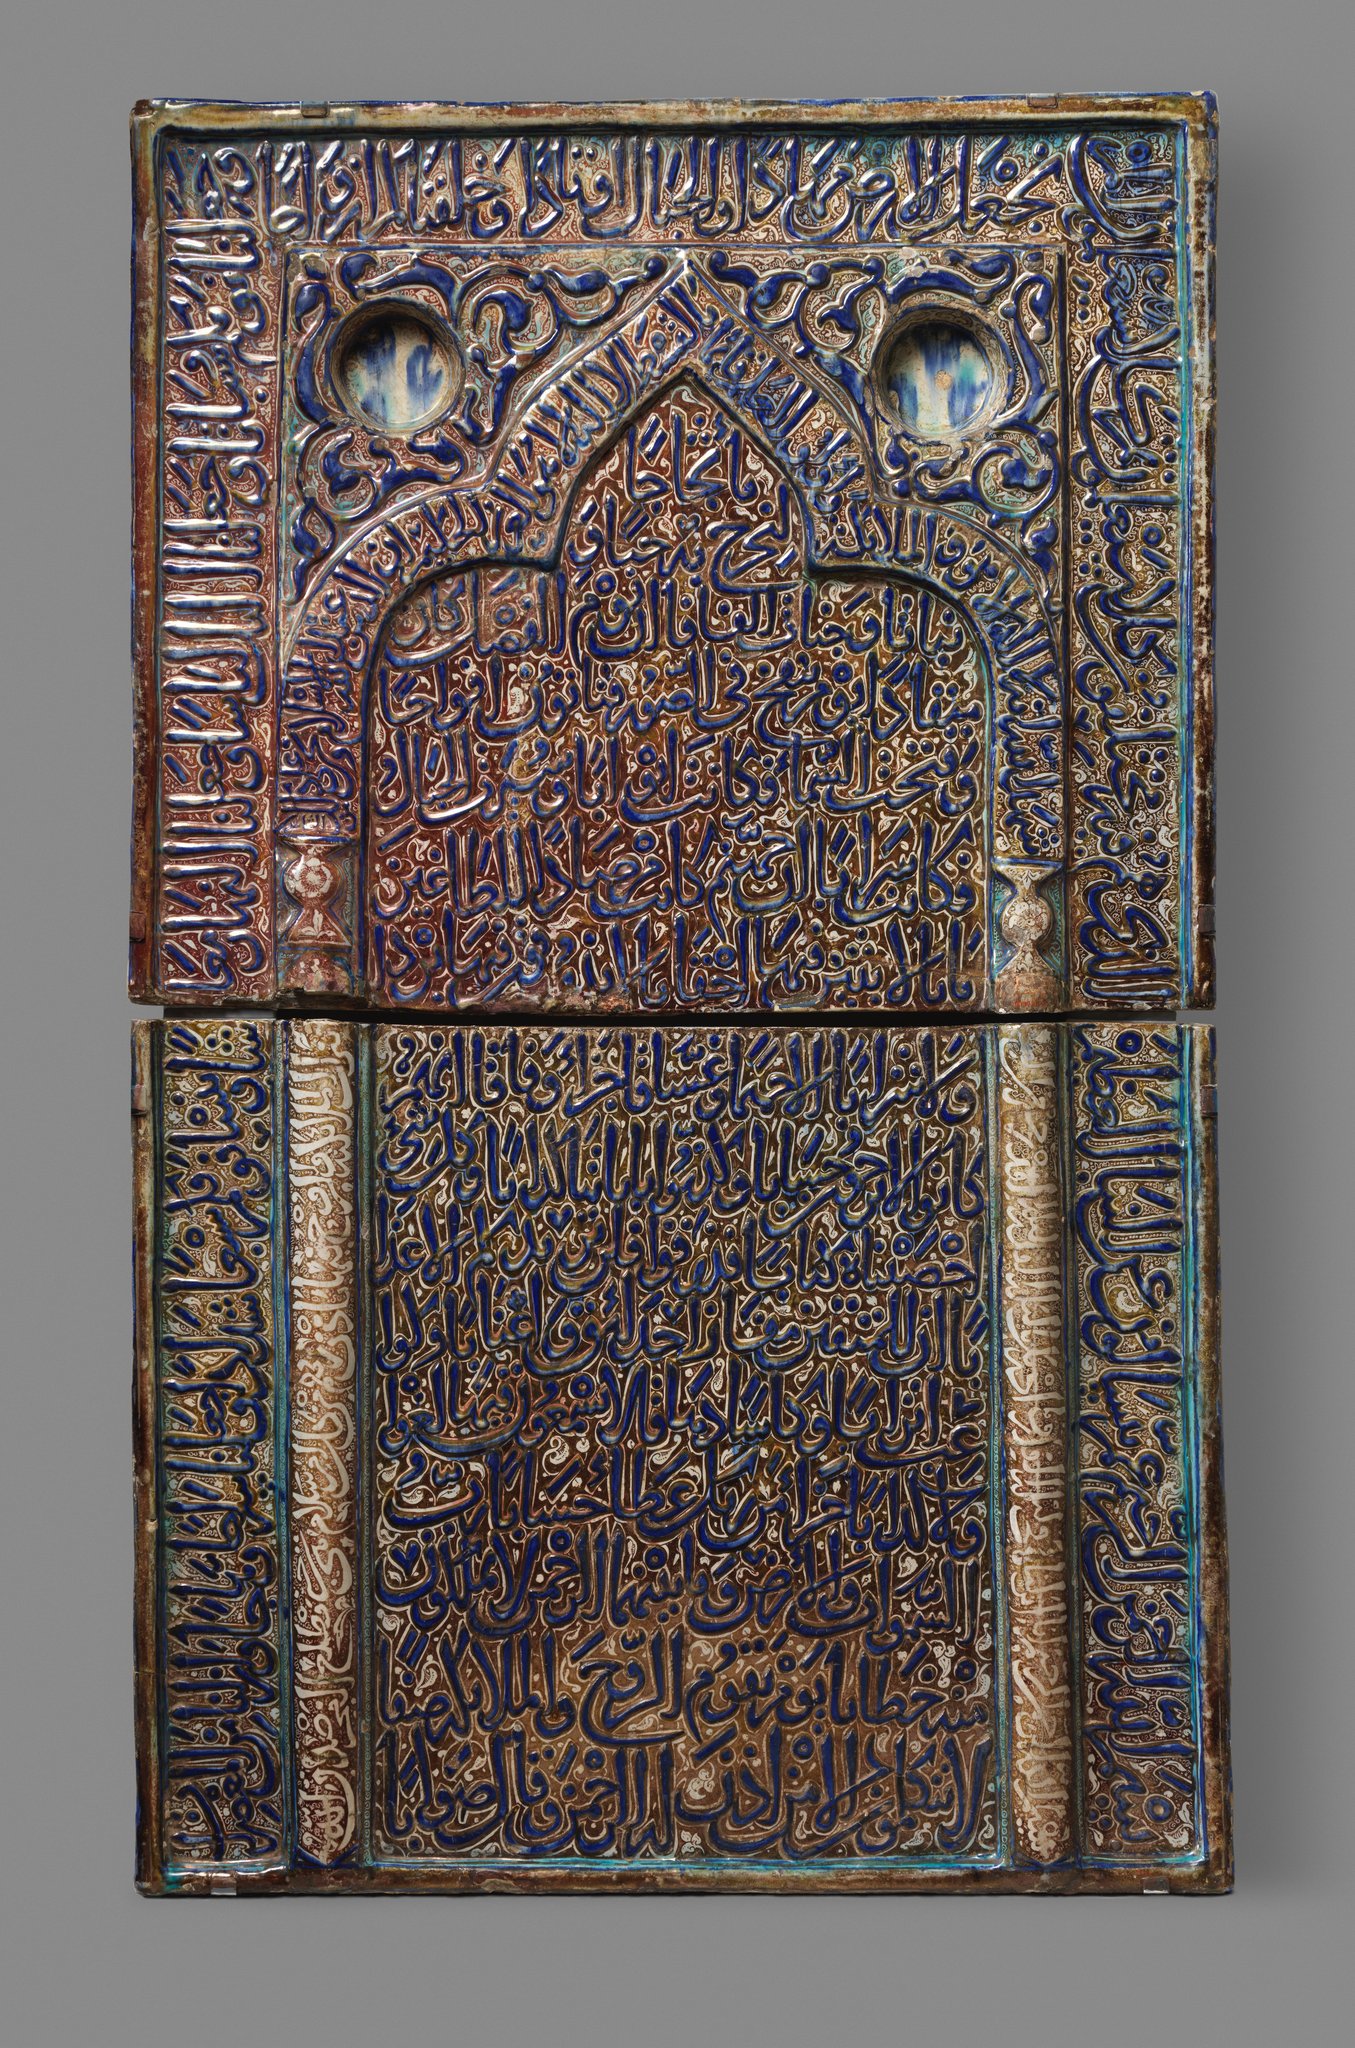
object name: tile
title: Tile with Niche Design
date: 1301-1333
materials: stonepaste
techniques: luster painting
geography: iran